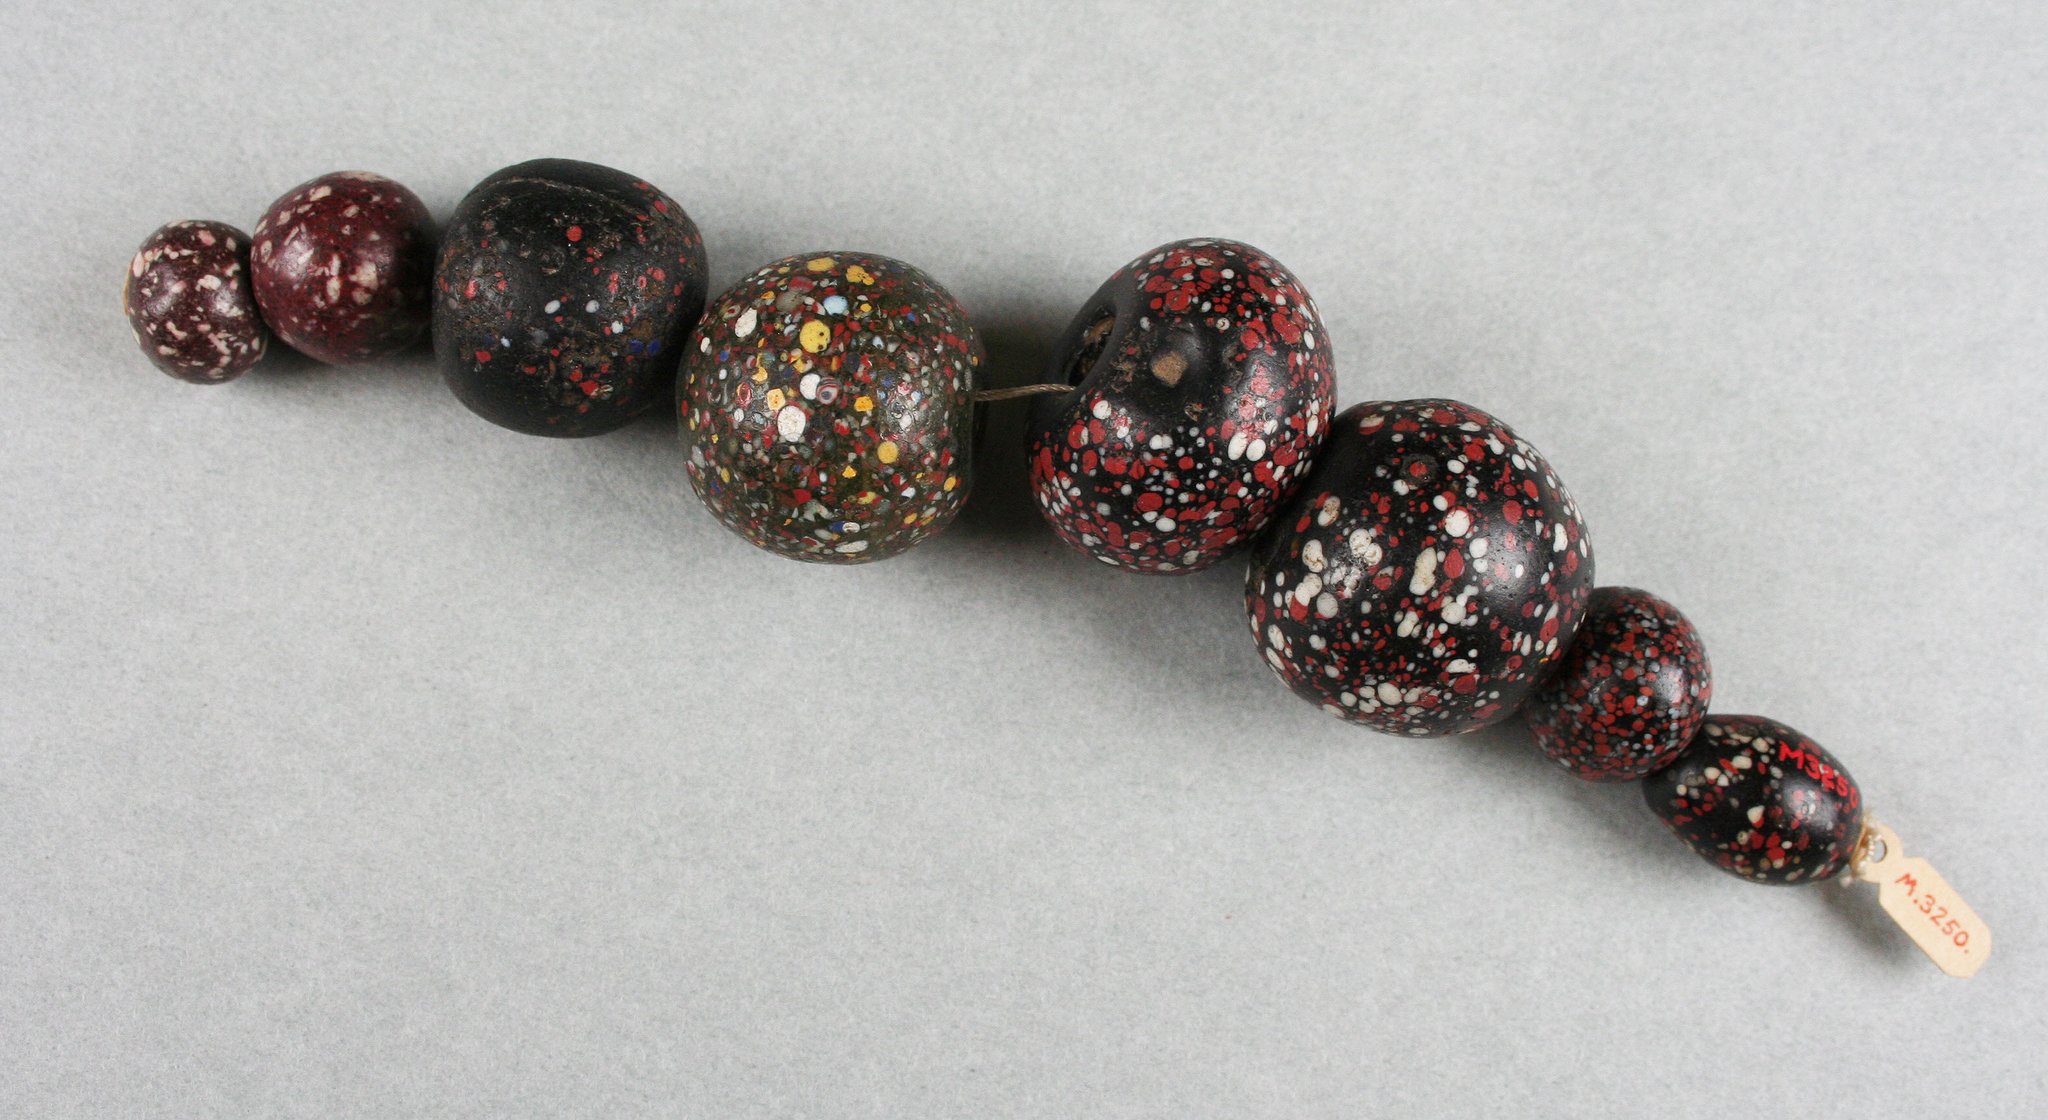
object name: bead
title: Beads, string of eight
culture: african or european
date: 1701-1800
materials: glass